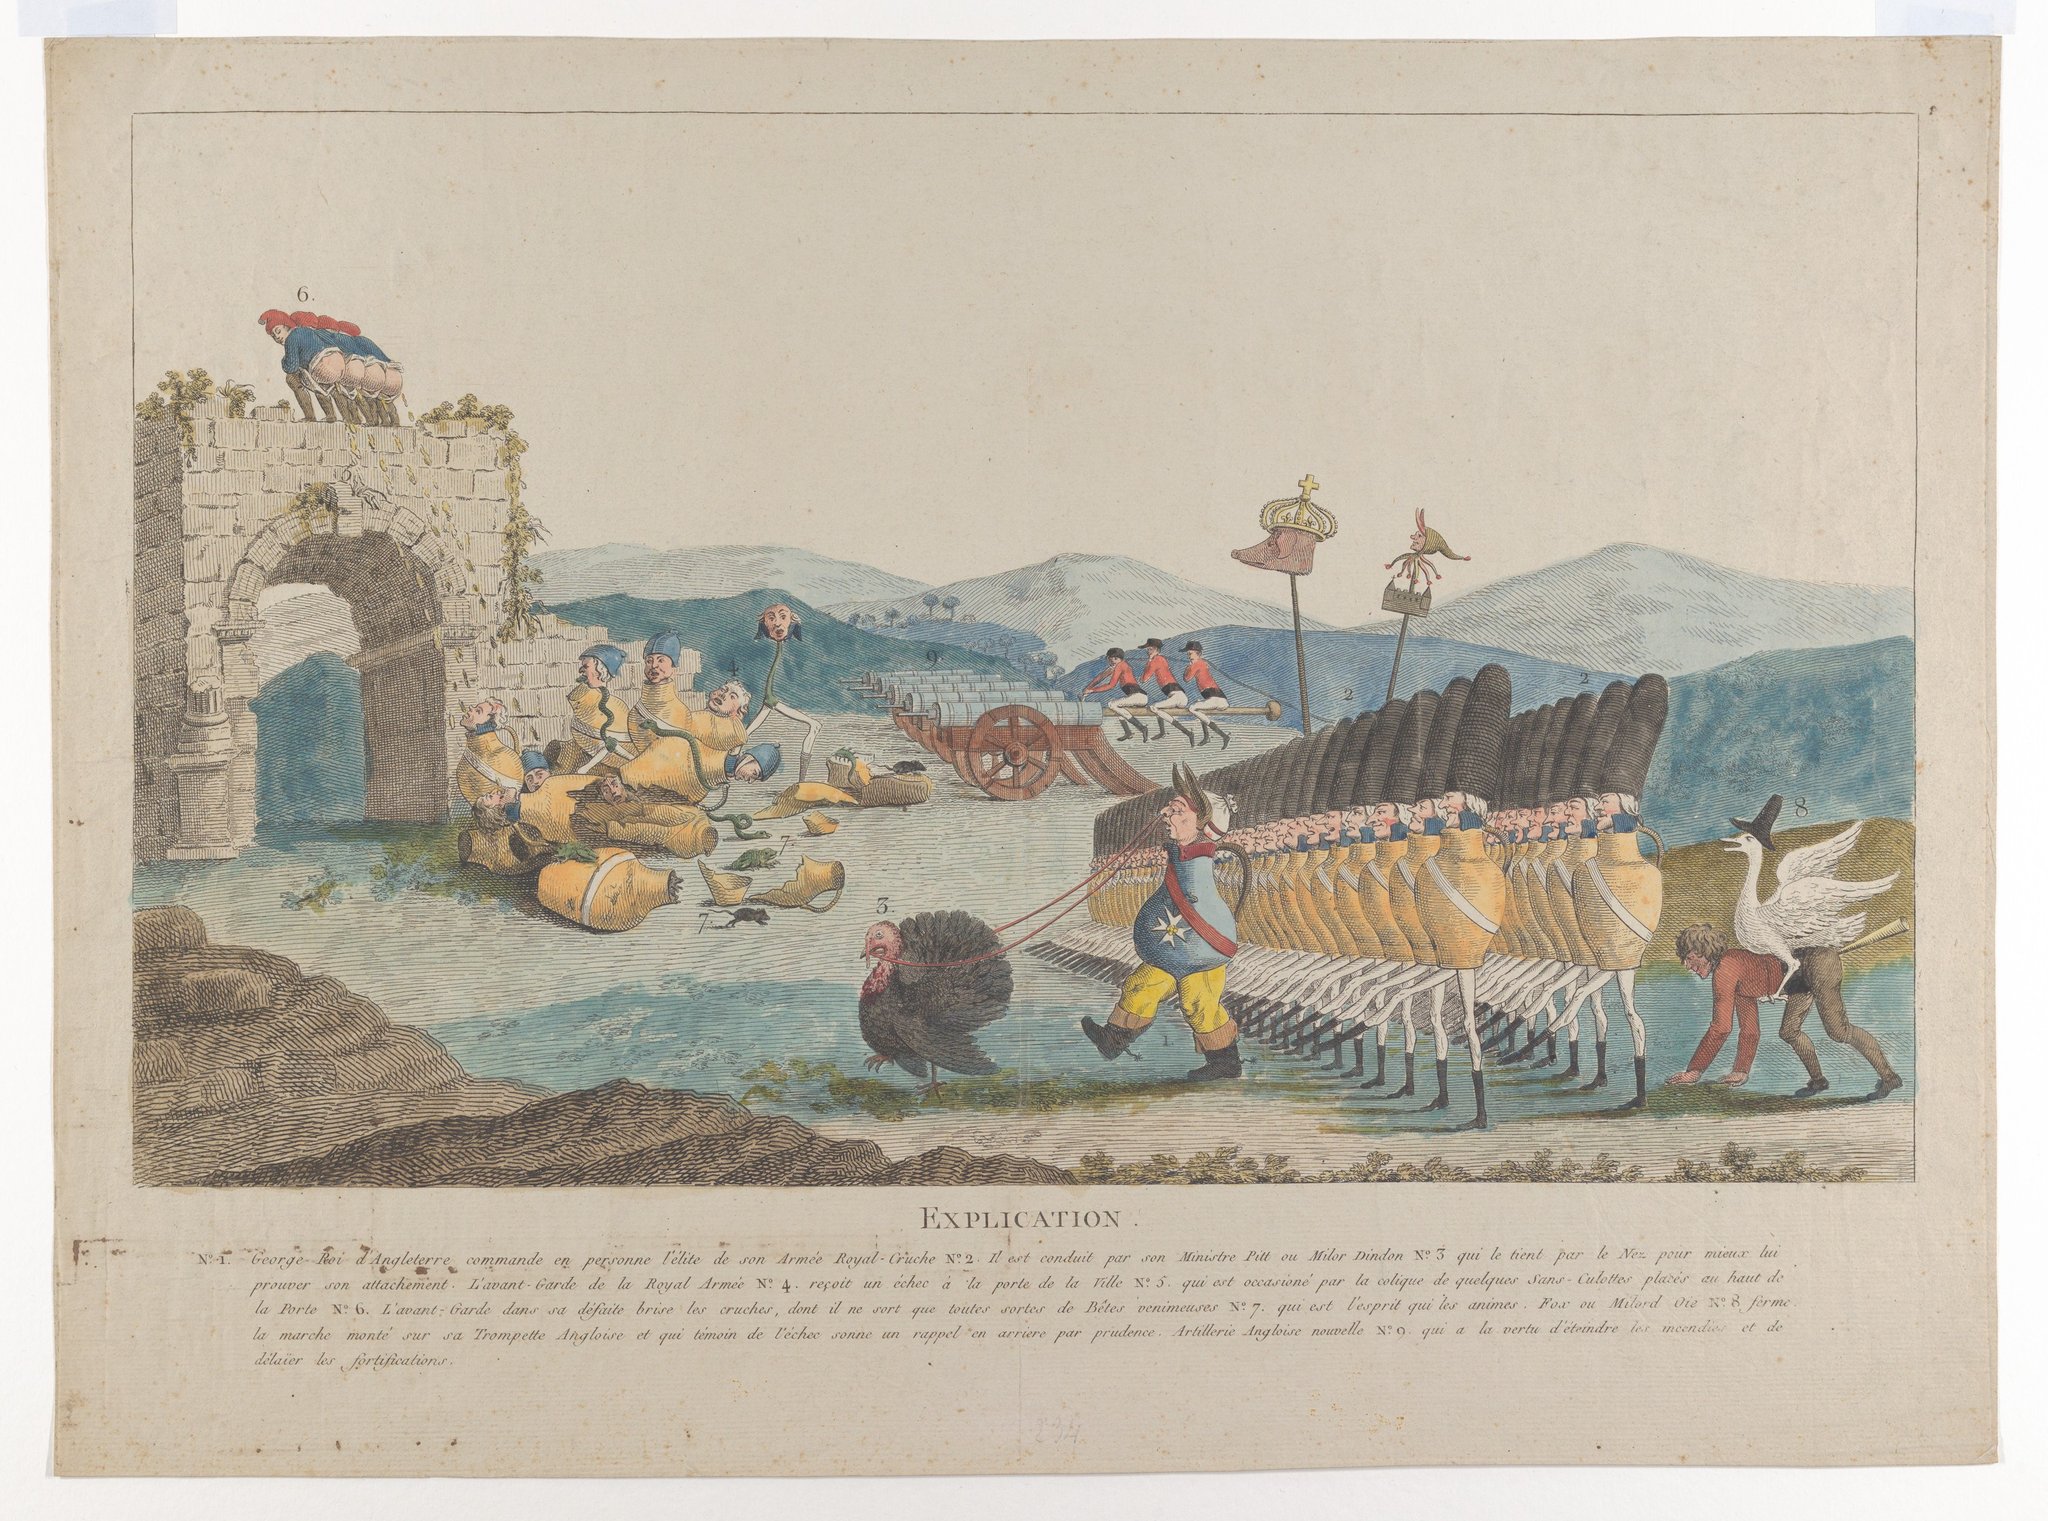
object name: print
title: George III Leading an Army of Jugs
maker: jacques louis david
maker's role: artist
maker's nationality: french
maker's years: 1748-1825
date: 1794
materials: watercolor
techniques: etching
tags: satire,kings,turkeys,jugs,caricature,george iii